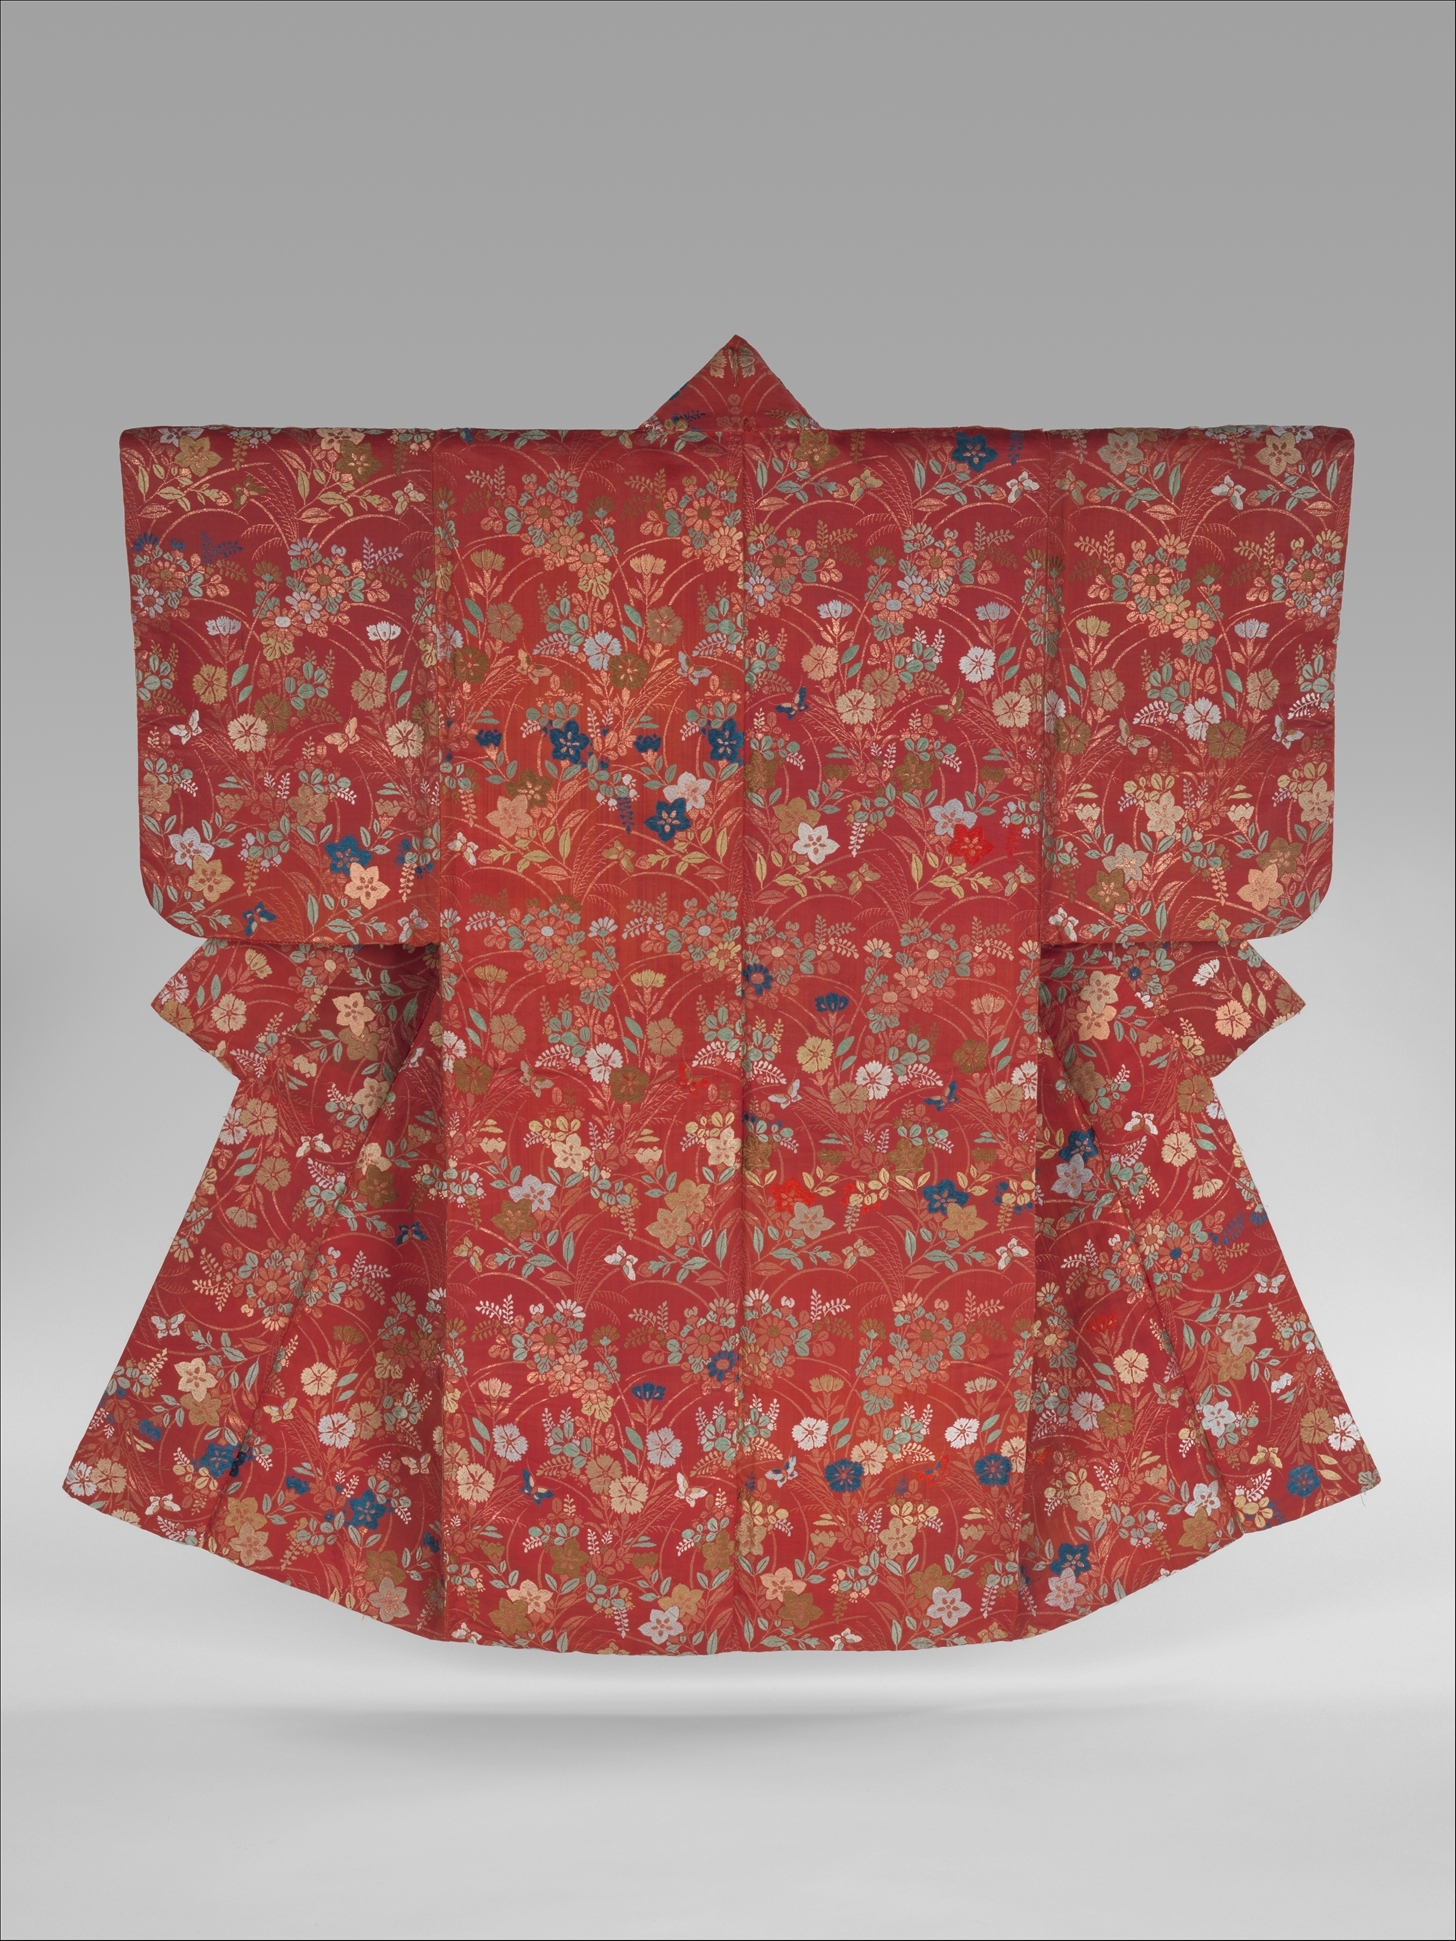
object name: noh costume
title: Noh Robe (Karaori) with Autumn Grasses and Butterflies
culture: japanese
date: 1801-1833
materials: metal thread, silk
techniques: brocade, patterning, weave